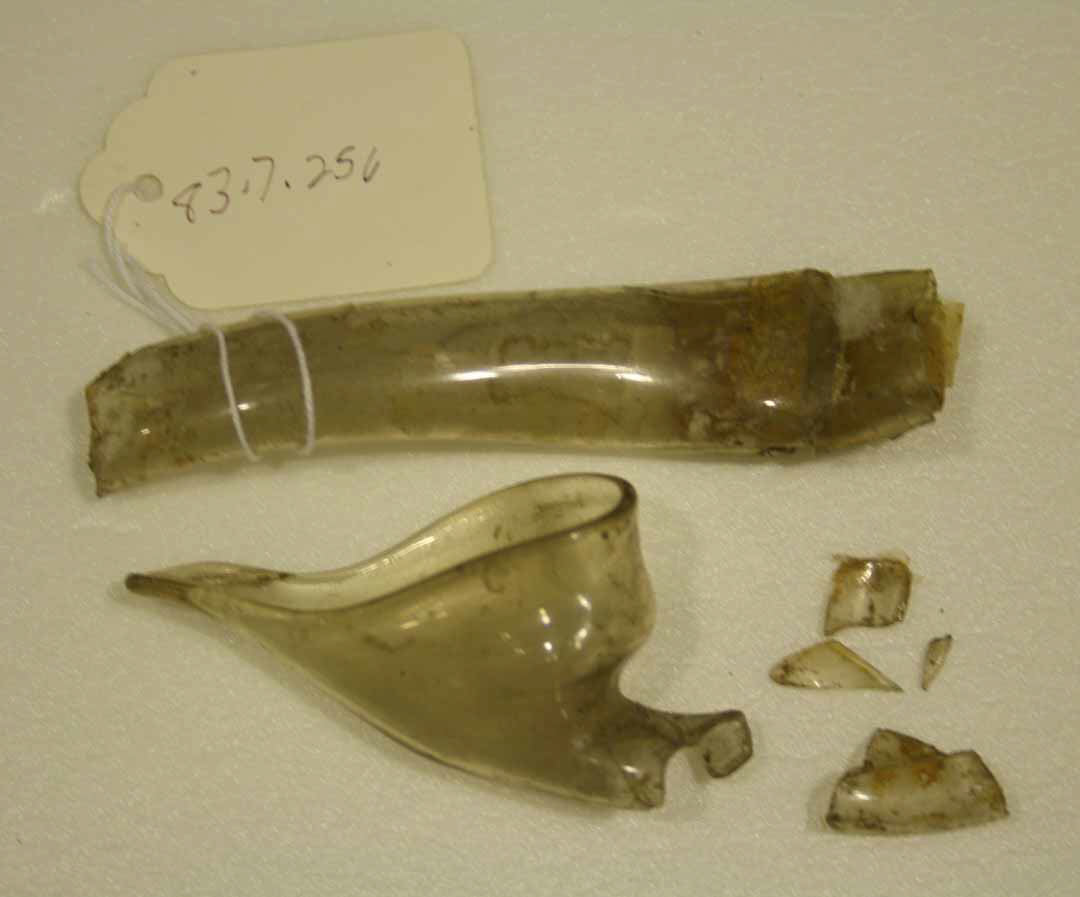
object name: bottle fragment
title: Fragments of a Bottle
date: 1701-1900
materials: glass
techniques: glassblowing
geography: iran